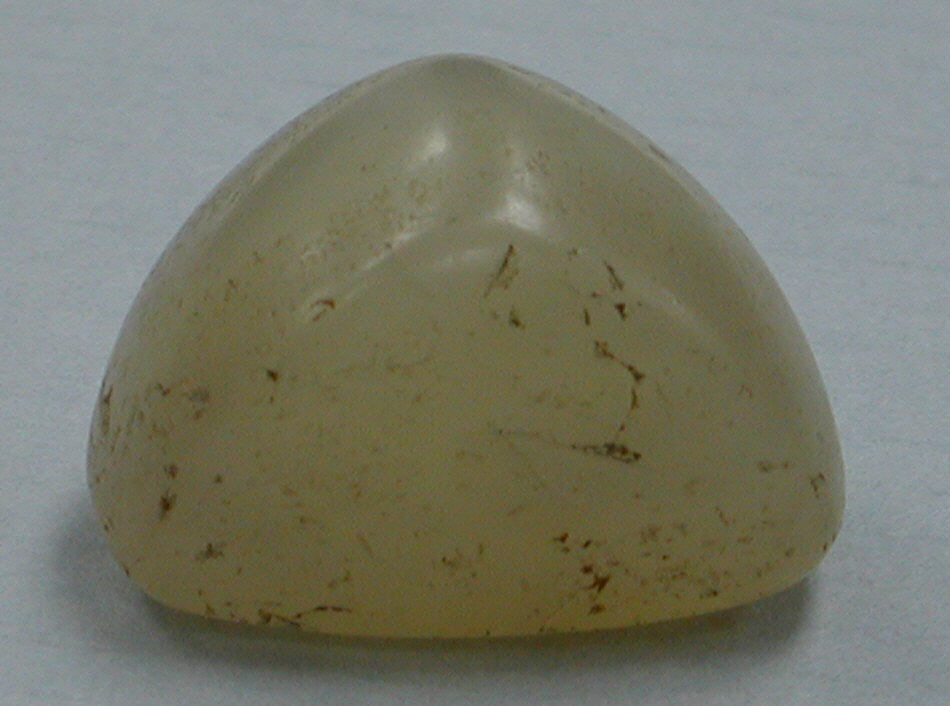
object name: ritual stone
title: Stone Pulidor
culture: mexican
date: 1501-1600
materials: stone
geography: mexico